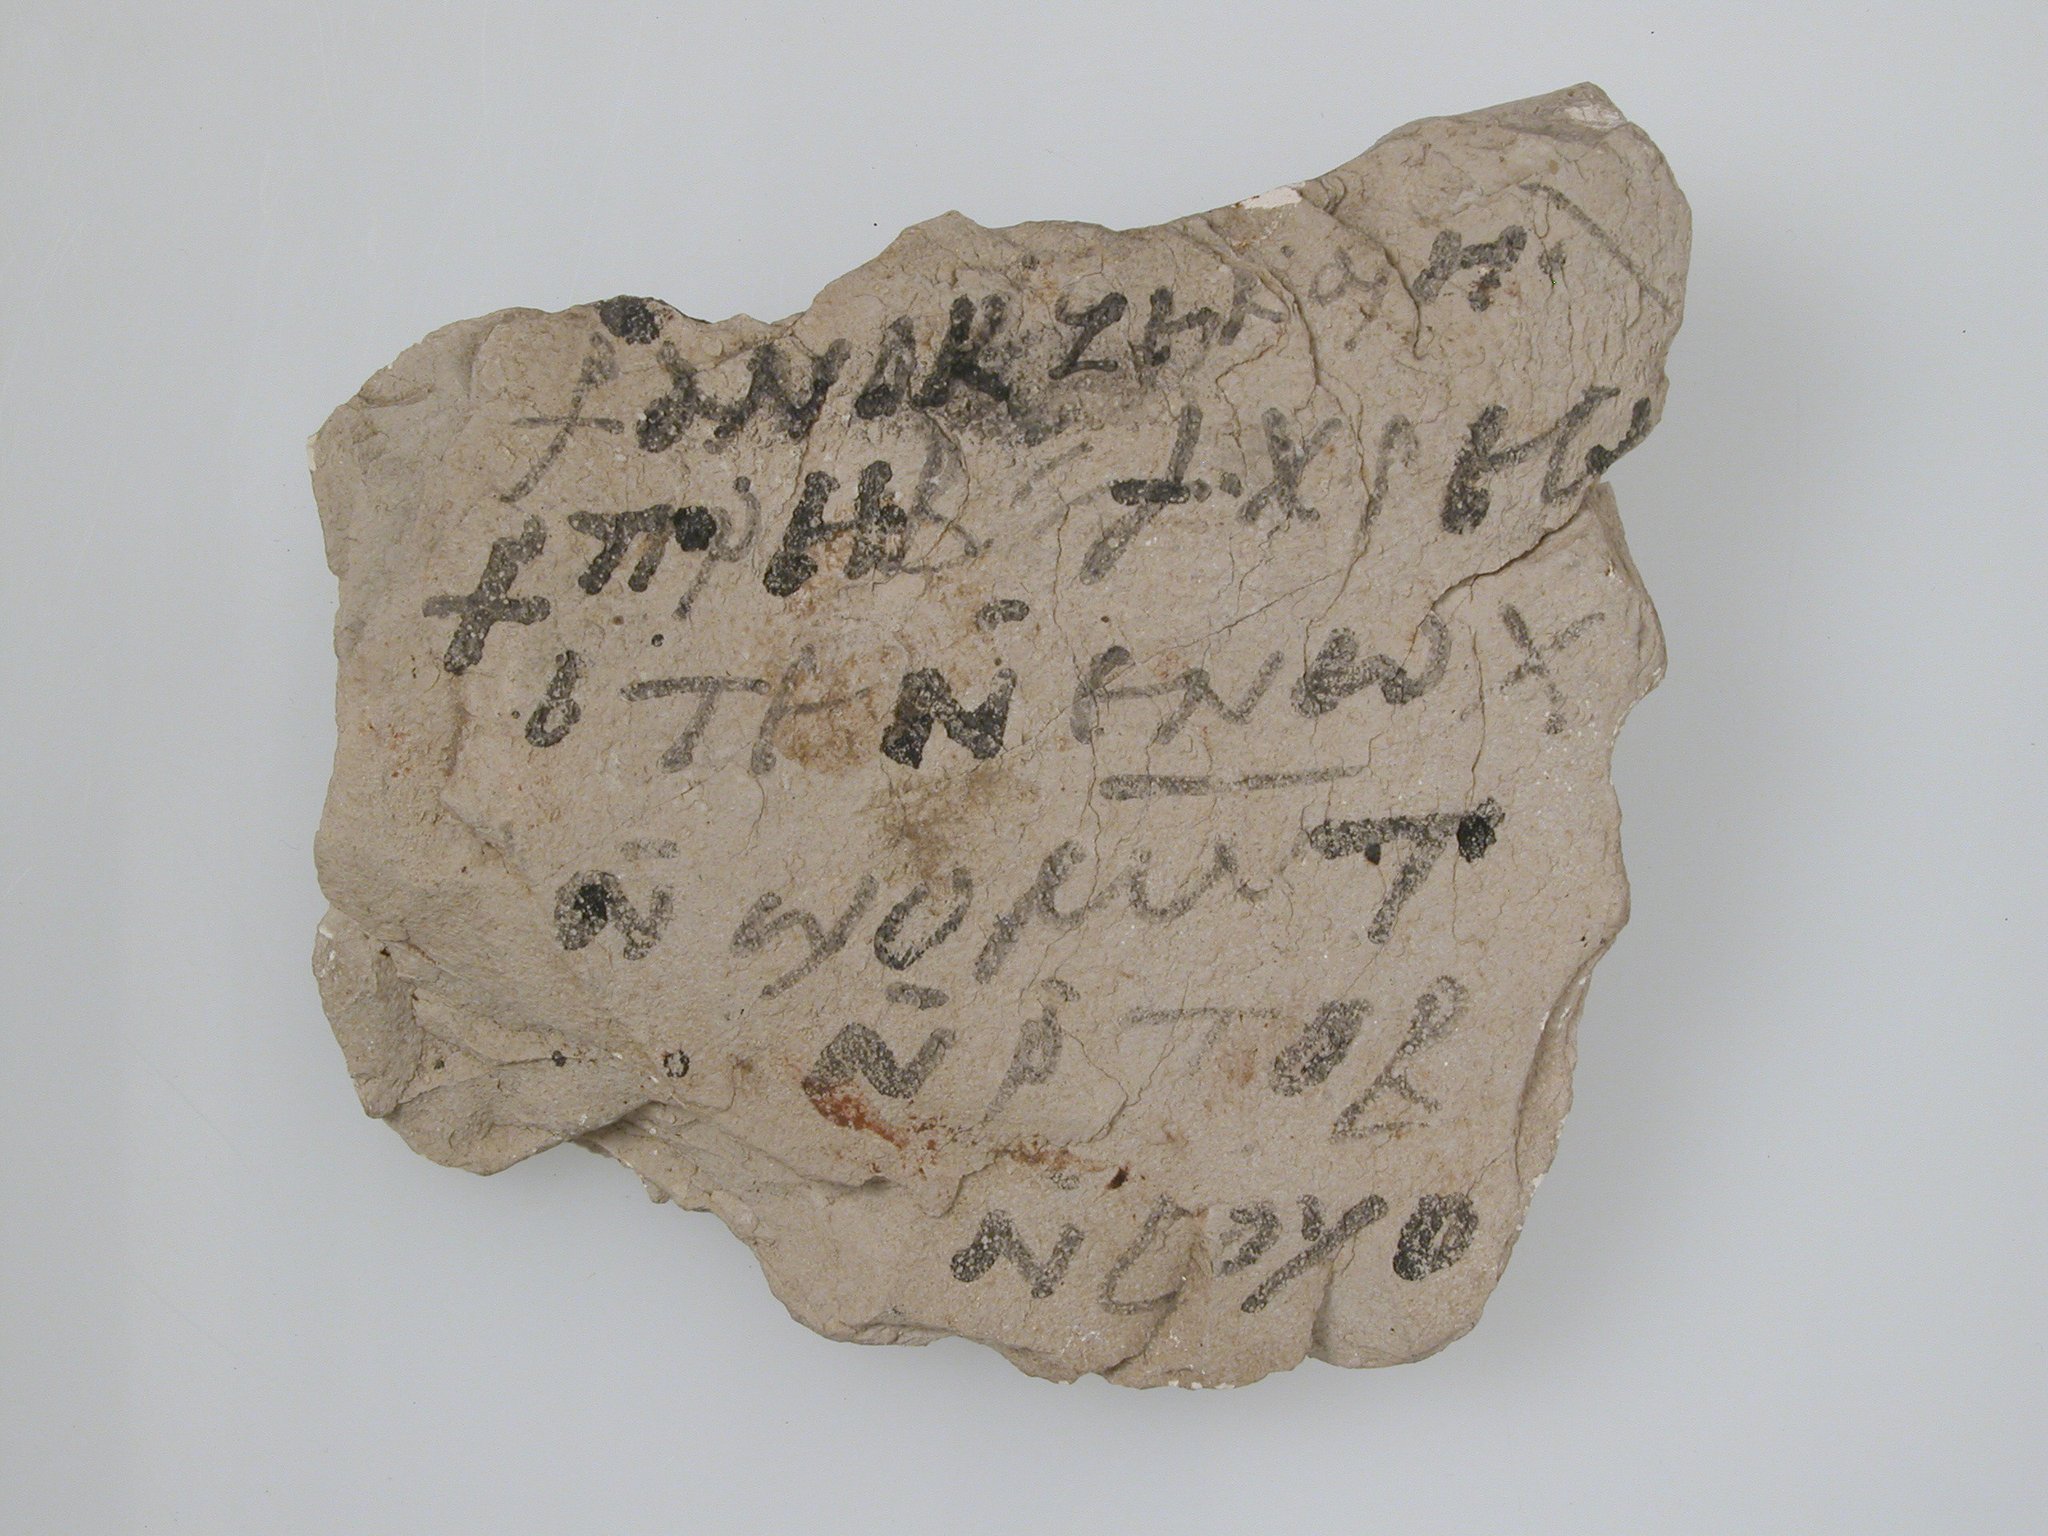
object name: ostrakon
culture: coptic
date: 601-700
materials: ink, limestone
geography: egypt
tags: documents